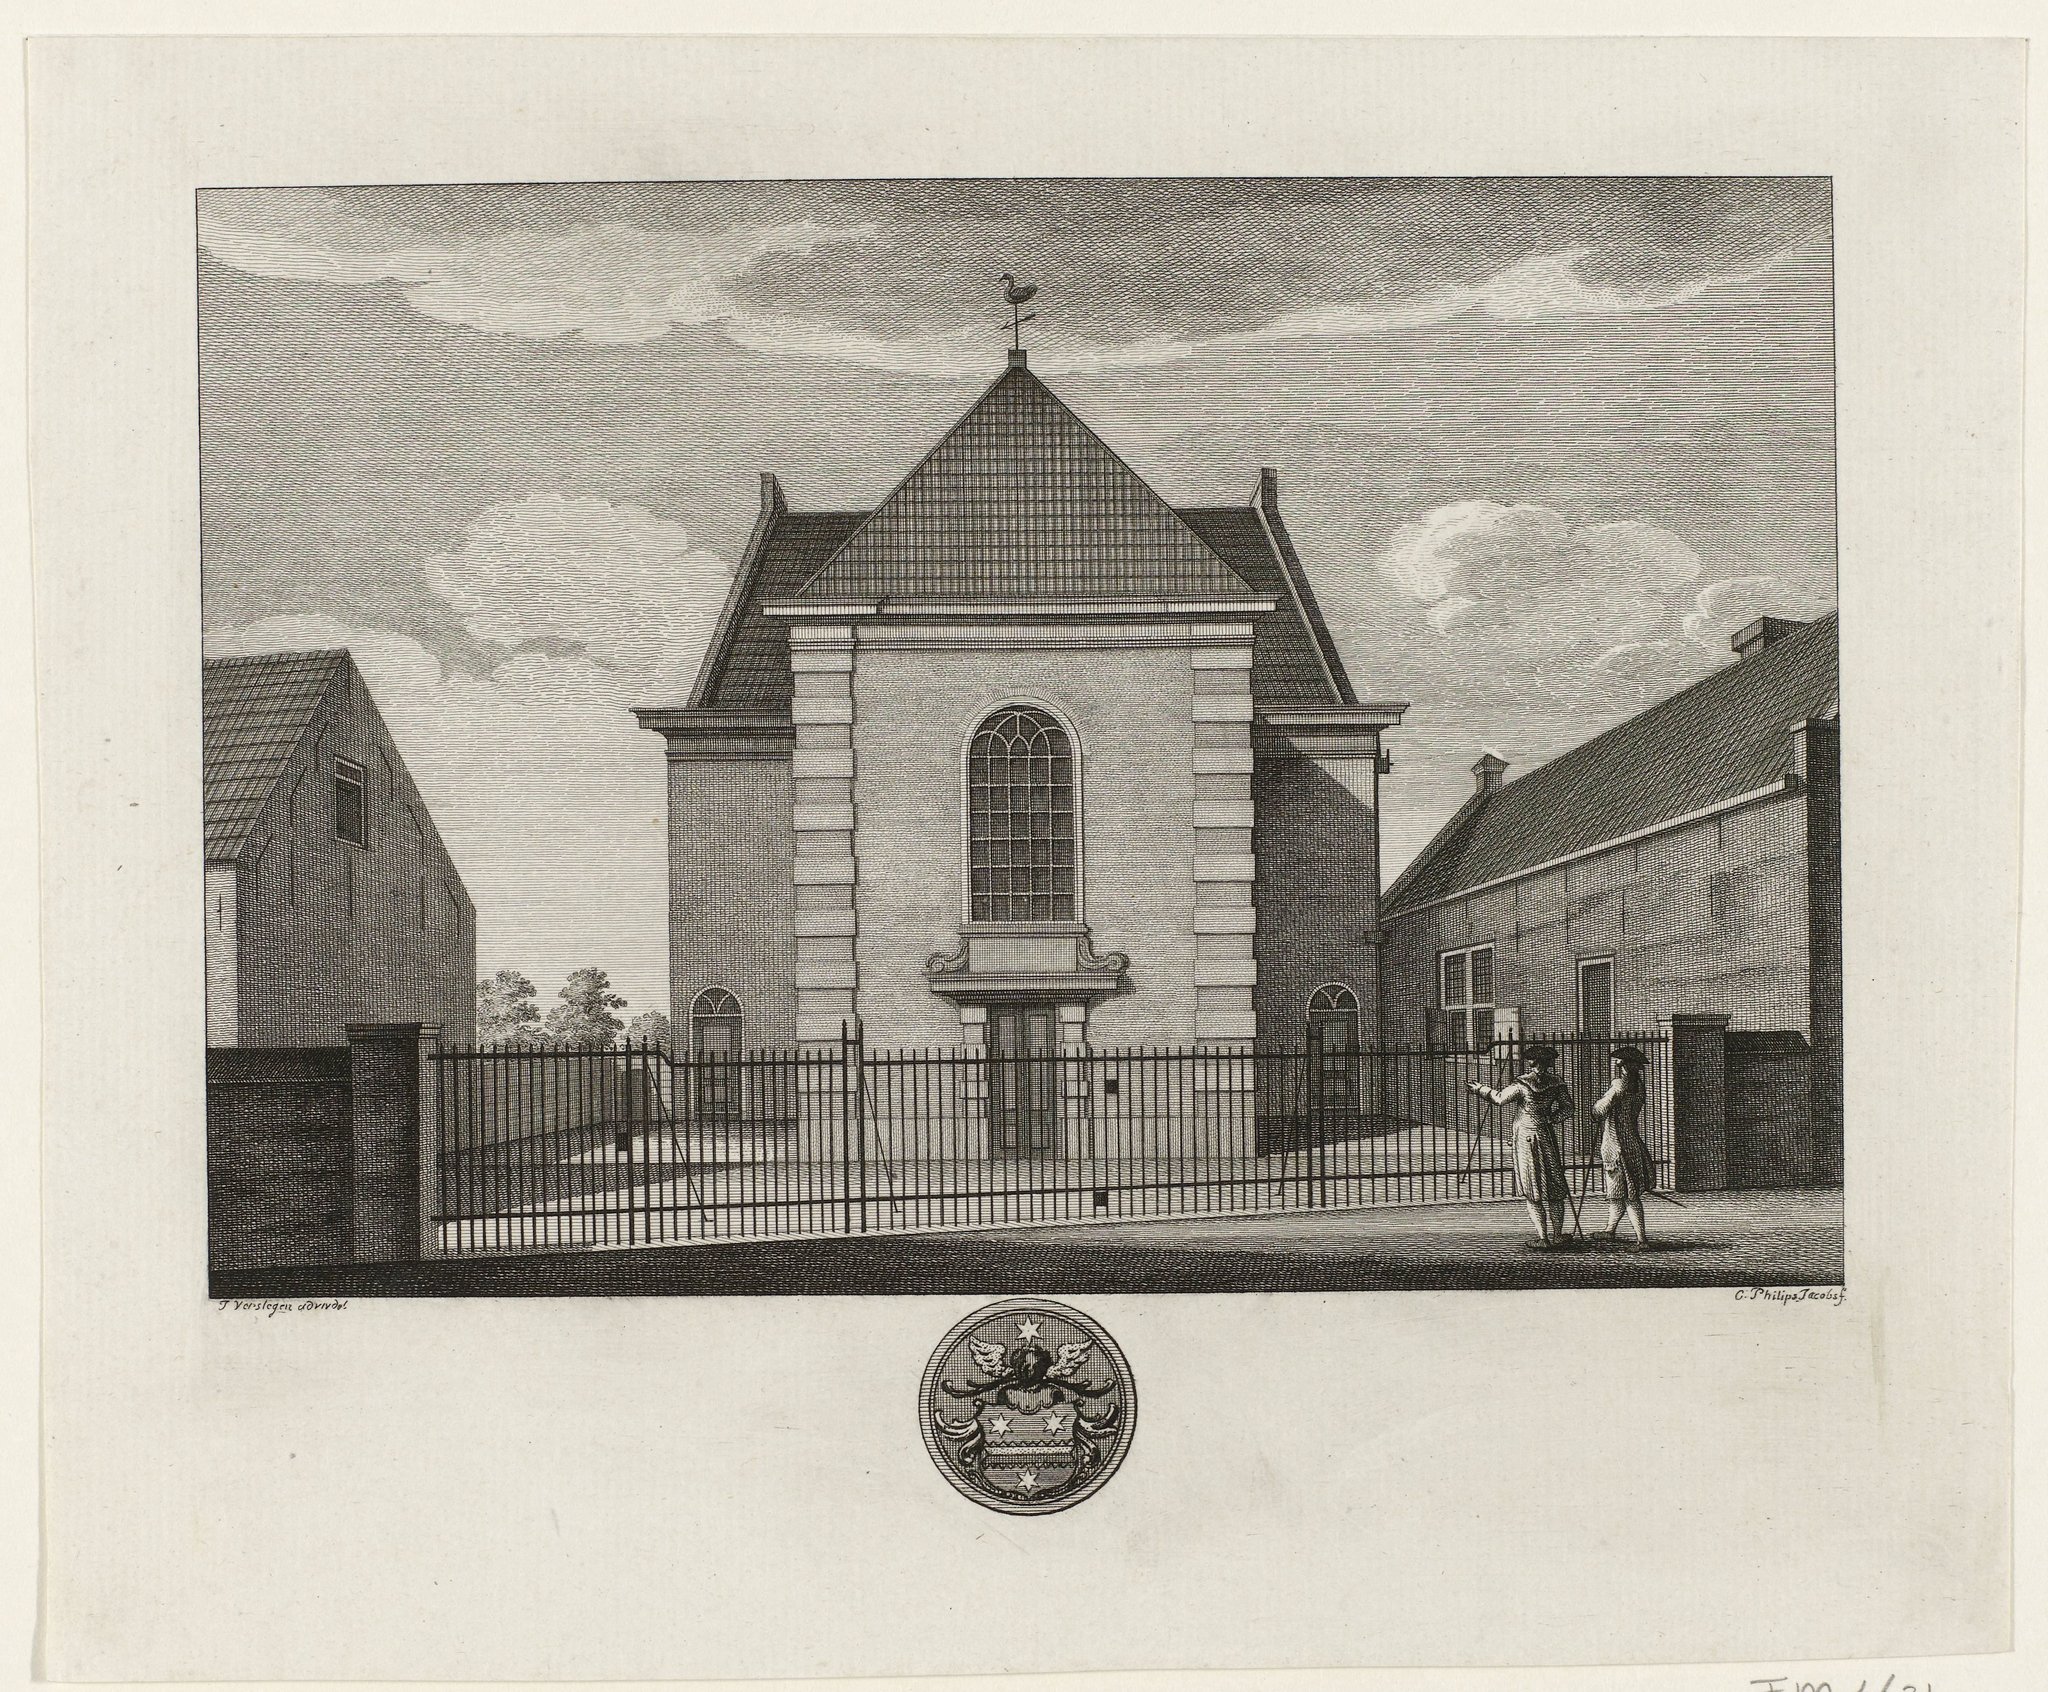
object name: print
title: Lutherse kerk te Beverwijk verkocht in 1785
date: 1779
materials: paper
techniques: engraving, etching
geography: northern netherlands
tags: joan coenraad brandt, church (exterior)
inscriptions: collector's mark: Lugt 2228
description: De Lutherse kerk te Beverwijk, verkocht in 1785 aan de Amsterdammer Joan Coenraad Brandt. Onderaan een medaillon met wapen.